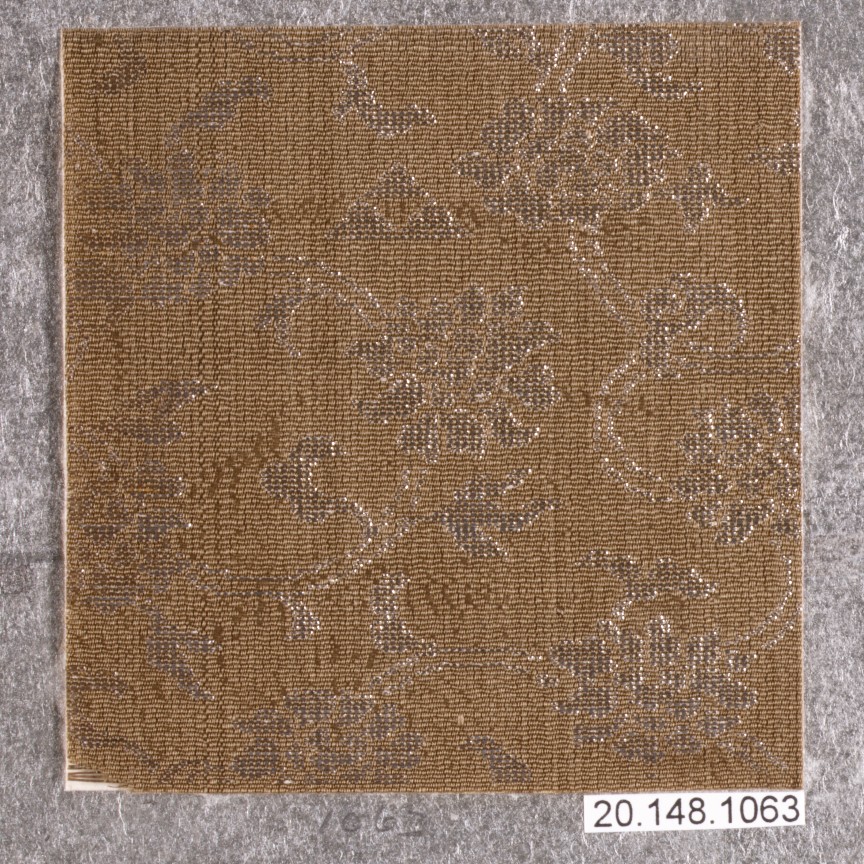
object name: piece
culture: chinese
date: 1701-1800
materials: silk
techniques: compound weave